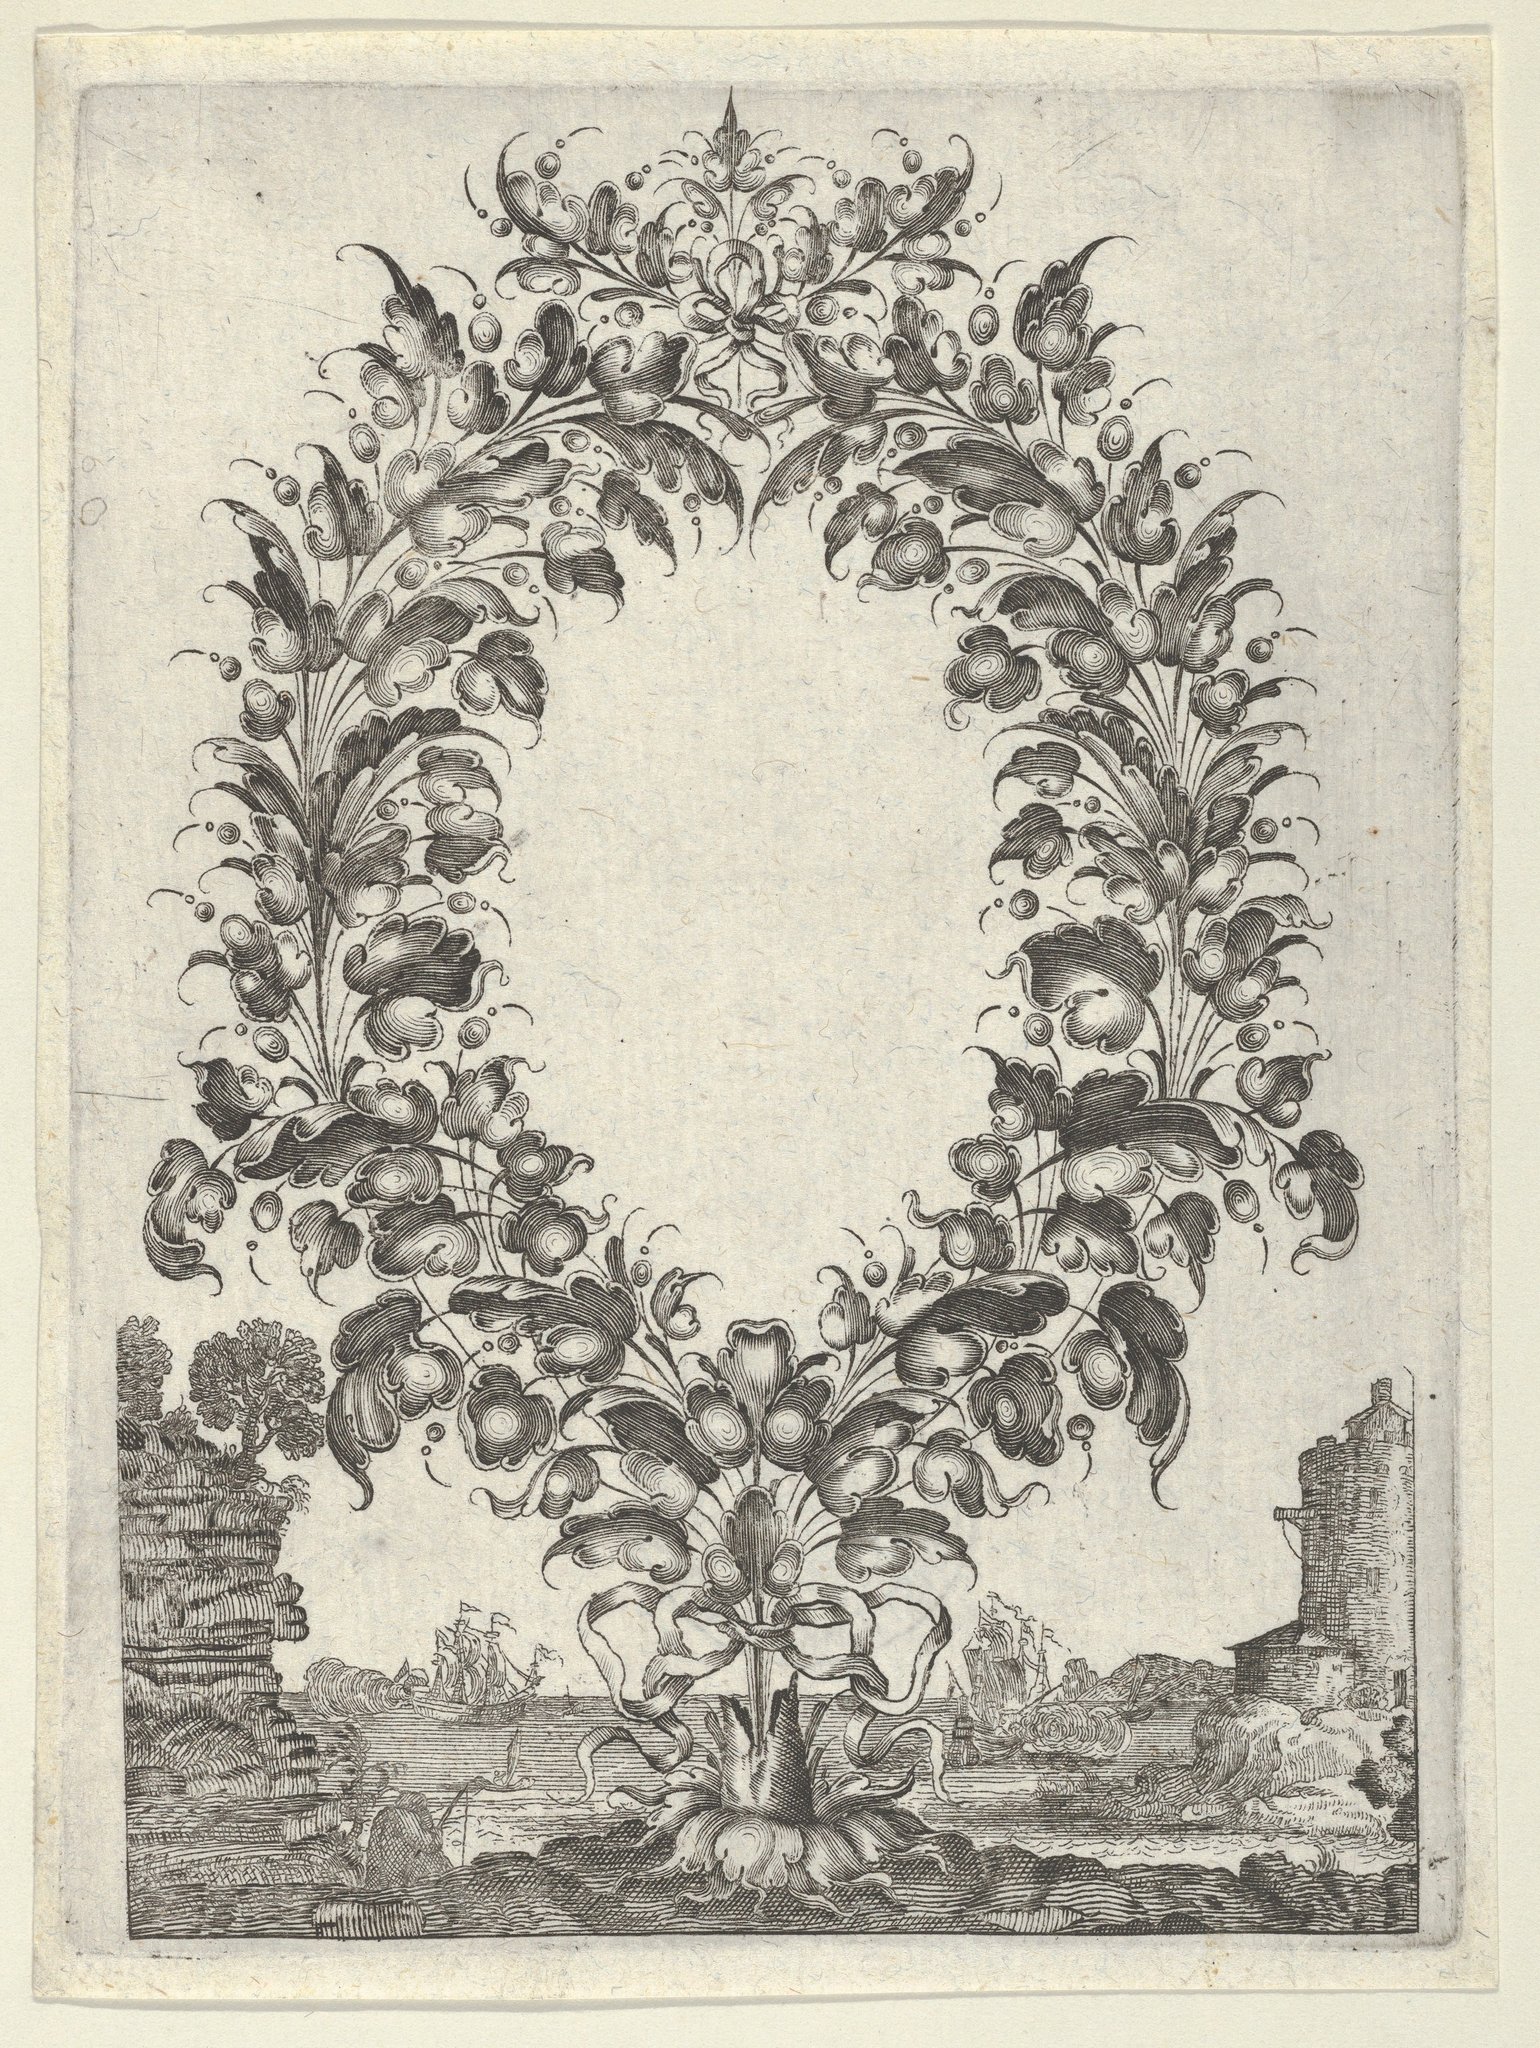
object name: print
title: Goldsmith's Bouquet, from "Newes Lauberbuechlein"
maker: peter aubry ii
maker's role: artist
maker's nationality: german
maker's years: 1610-1666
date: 1628-1666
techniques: engraving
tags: garlands,flowers,leaves